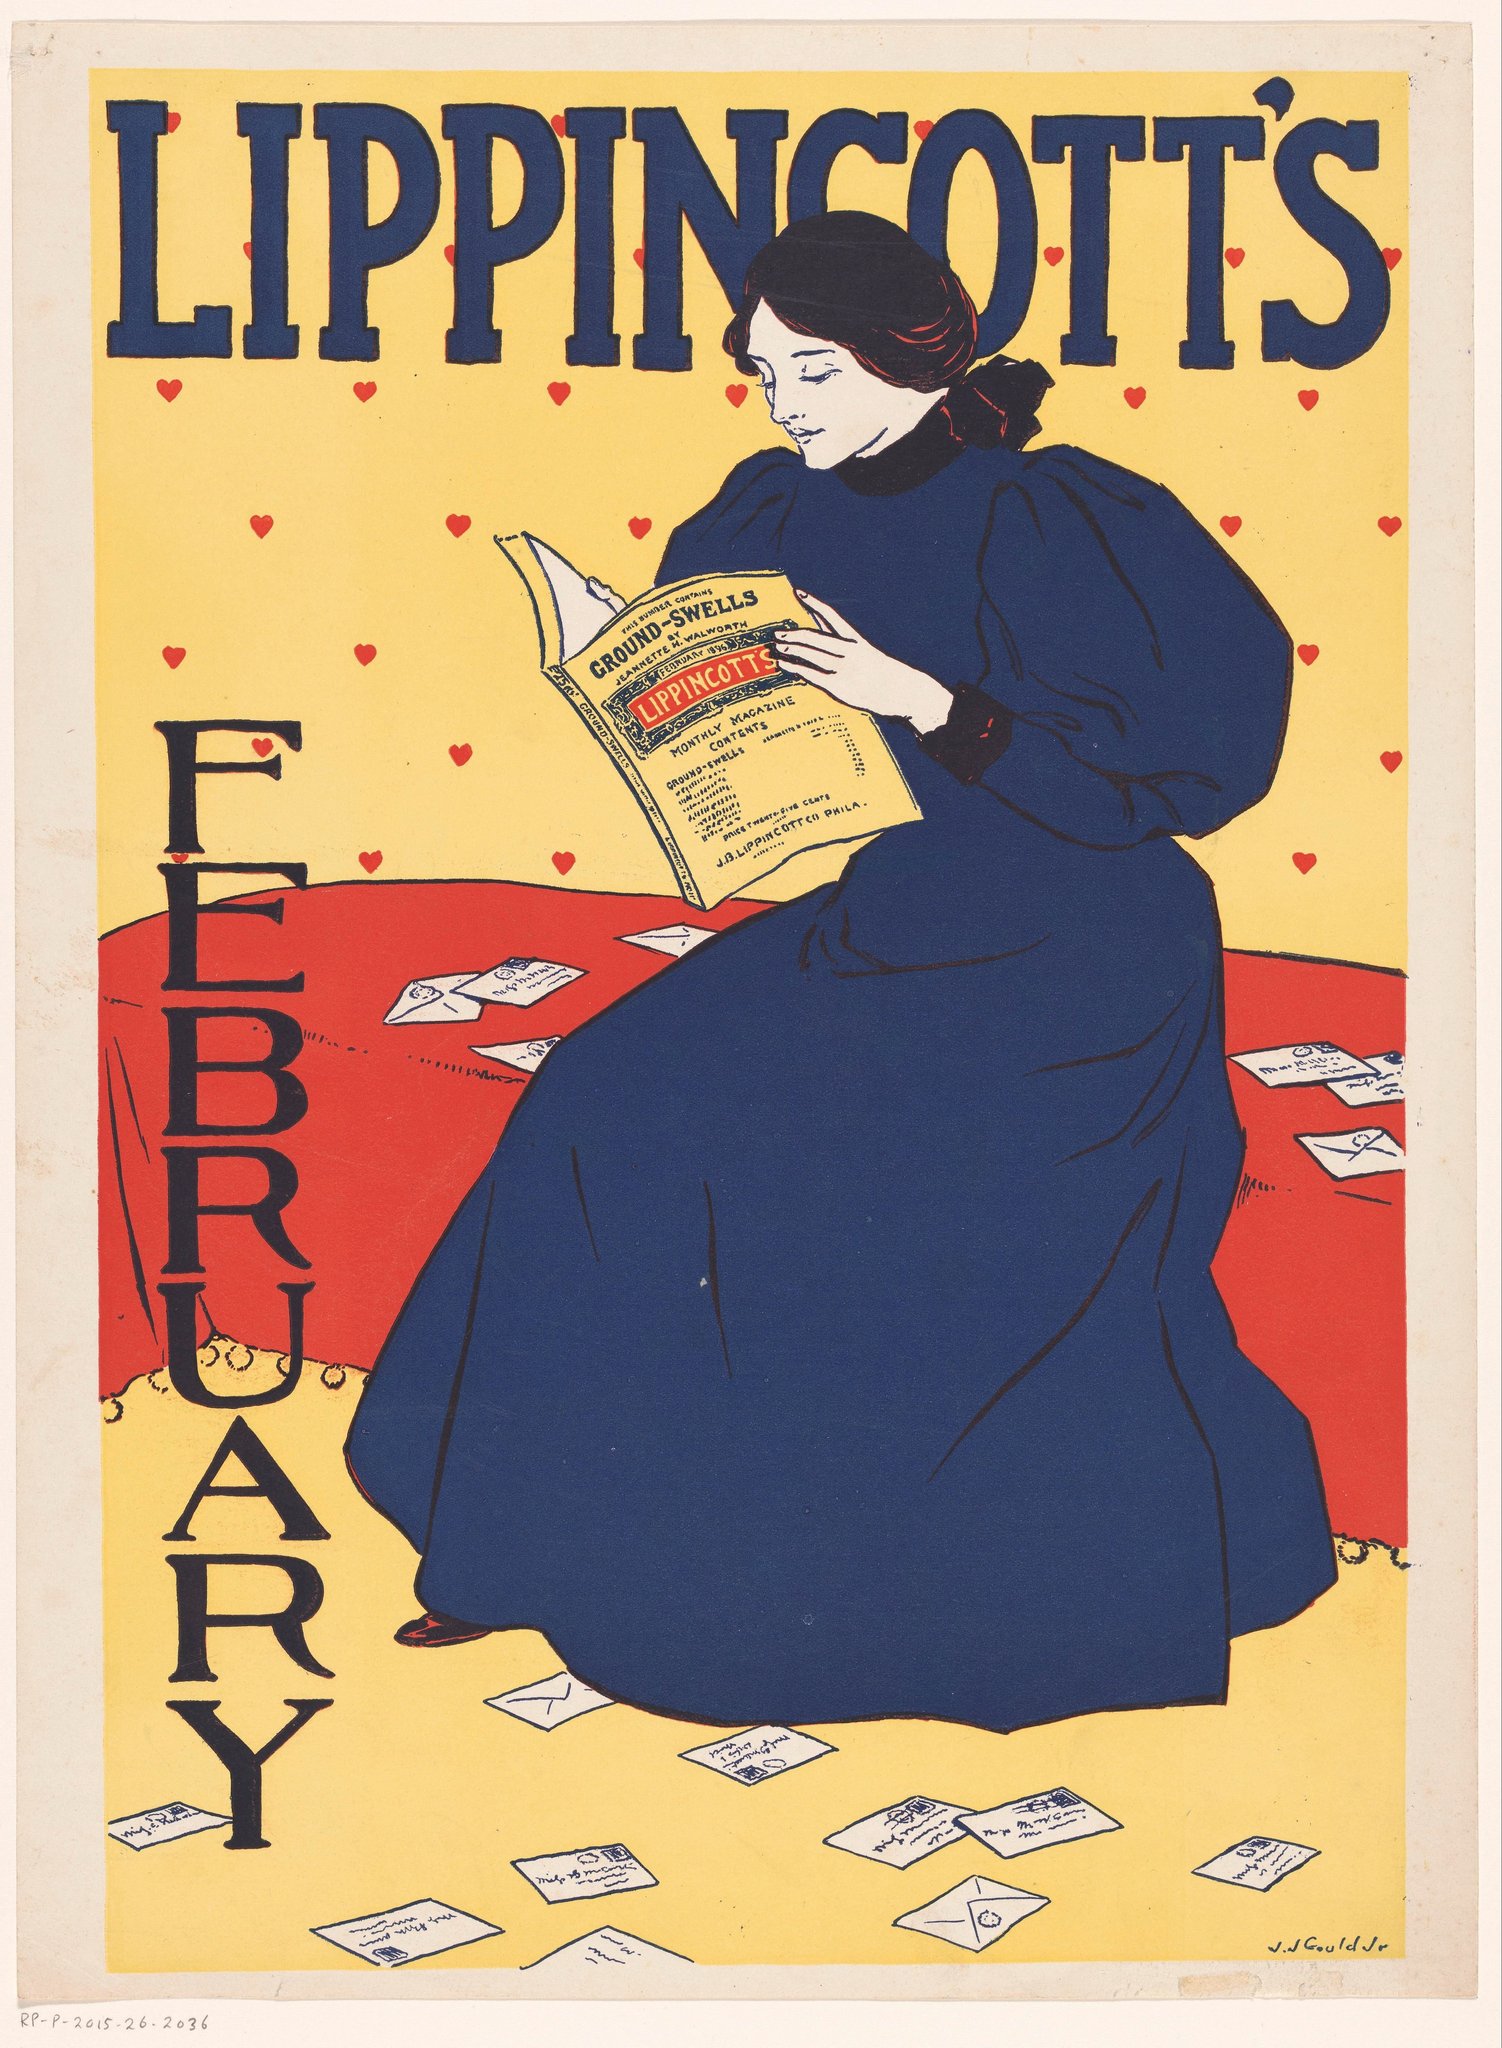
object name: poster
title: Advertentie voor een februarinummer van Lippincott's Monthly Magazine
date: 1896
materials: paper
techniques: lithograph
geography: philadelphia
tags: reading, weekly, monthly, magazine, etc., letter, envelope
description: Op een bank zit een vrouw te lezen in Lippincott's Monthly Magazine. Op de bank en op de grond liggen brieven.